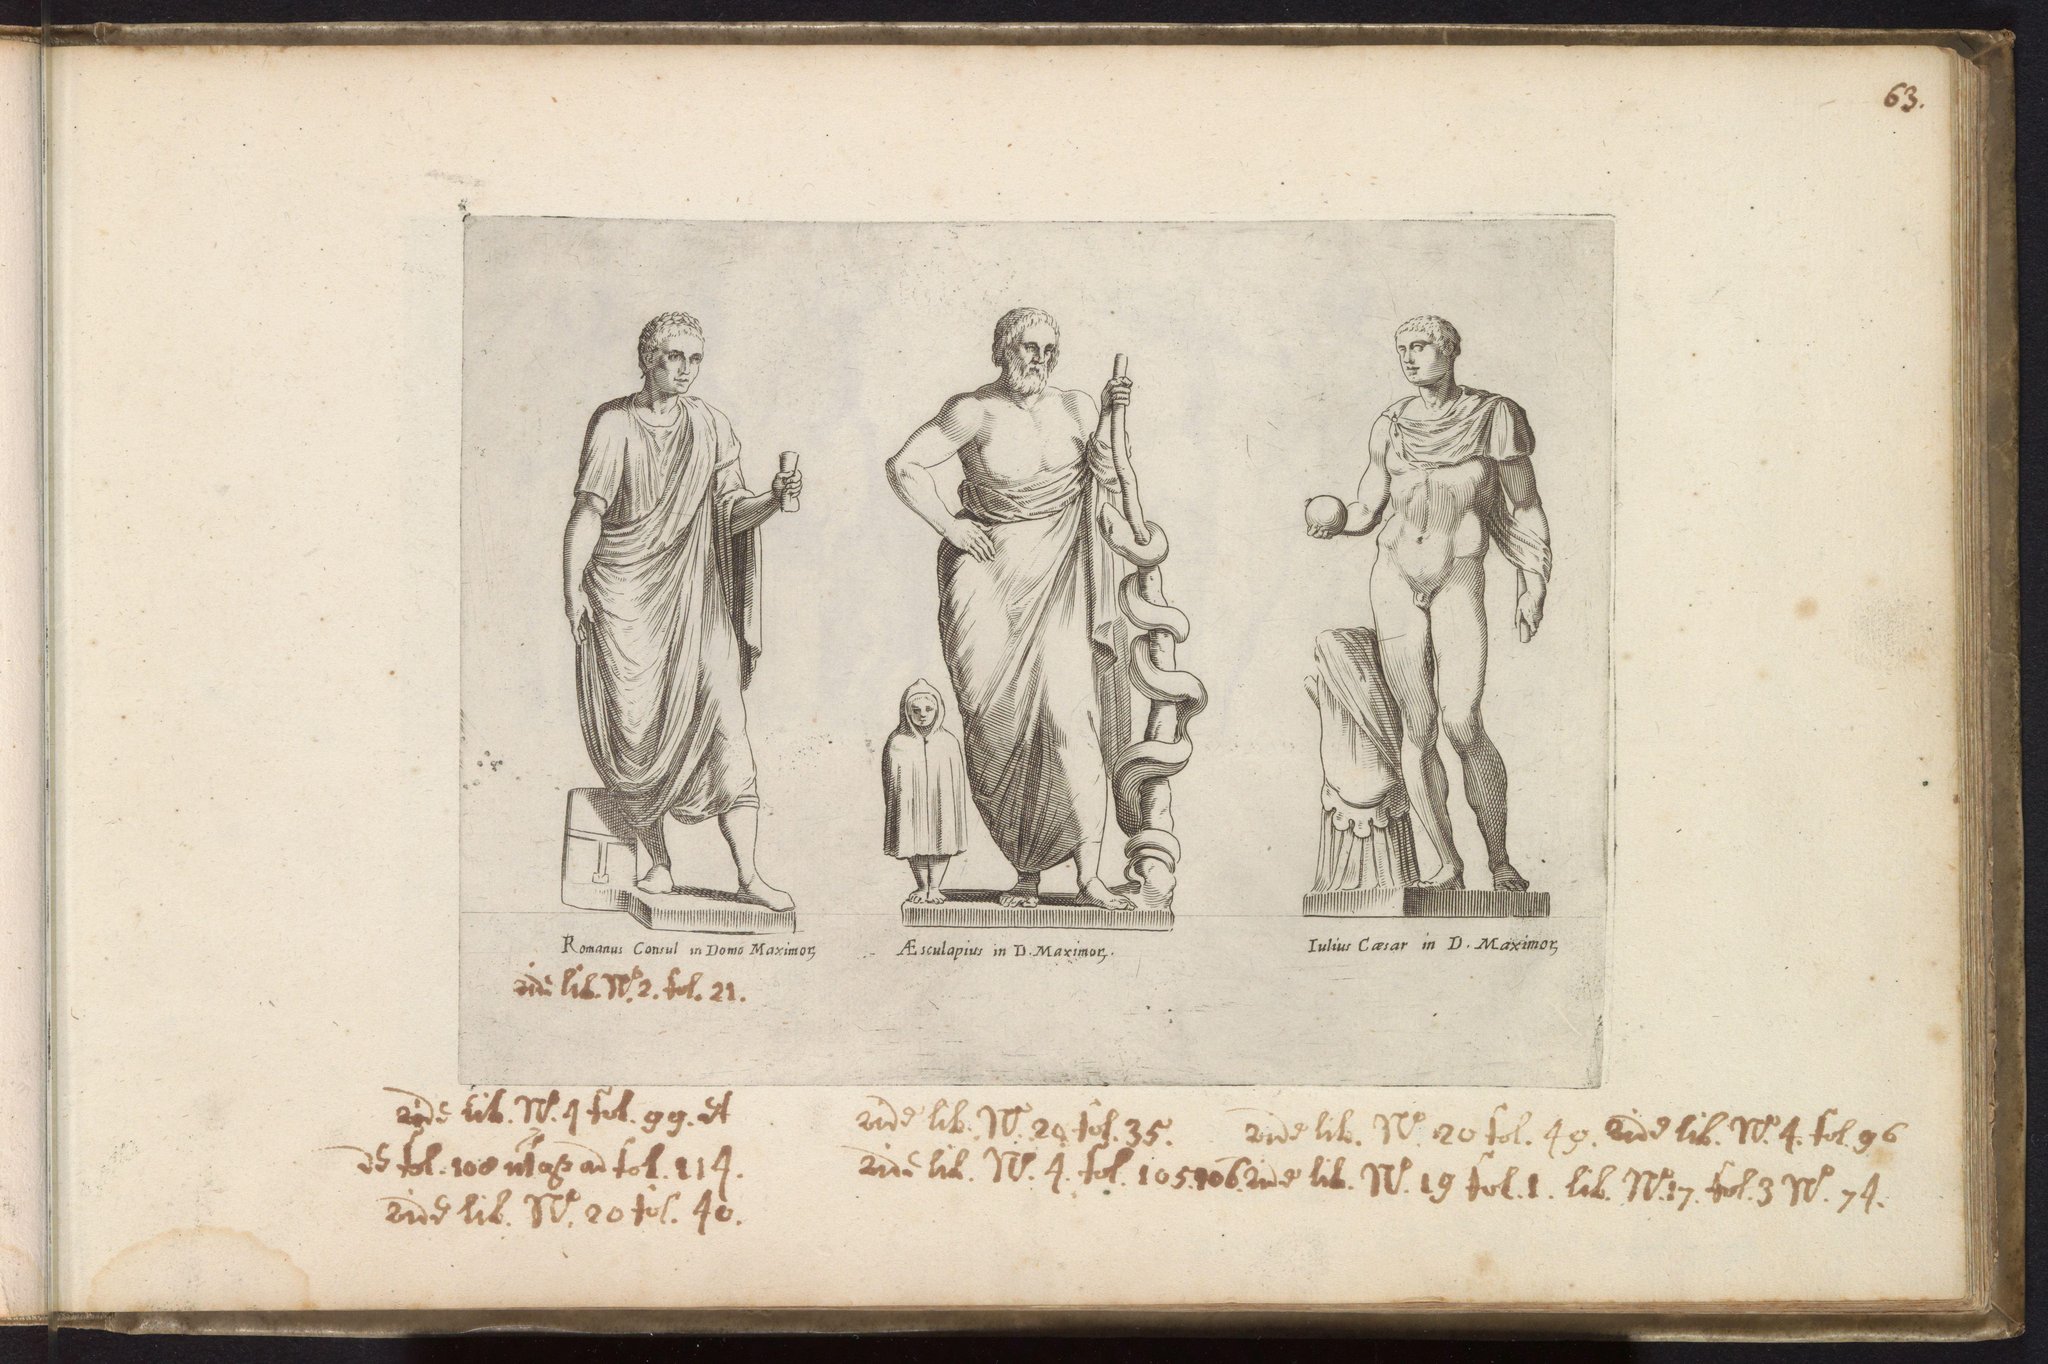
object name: album leaf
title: Sculpturen uit de oudheid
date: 1538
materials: paper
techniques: engraving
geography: italy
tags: politician, e.g. party leader, piece of sculpture, reproduction of a piece of sculpture, (story of) c. julius caesar, (story of) aesculapius (asclepius)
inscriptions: inscription: ‘Ende lib. No. 4 fol. 99 et/ [...] fol. 108 [...] fol. 214...’, number: ‘63’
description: Deze prent maakt deel uit van een reeks van ten minste 19 prenten van sculpturen uit de oudheid.